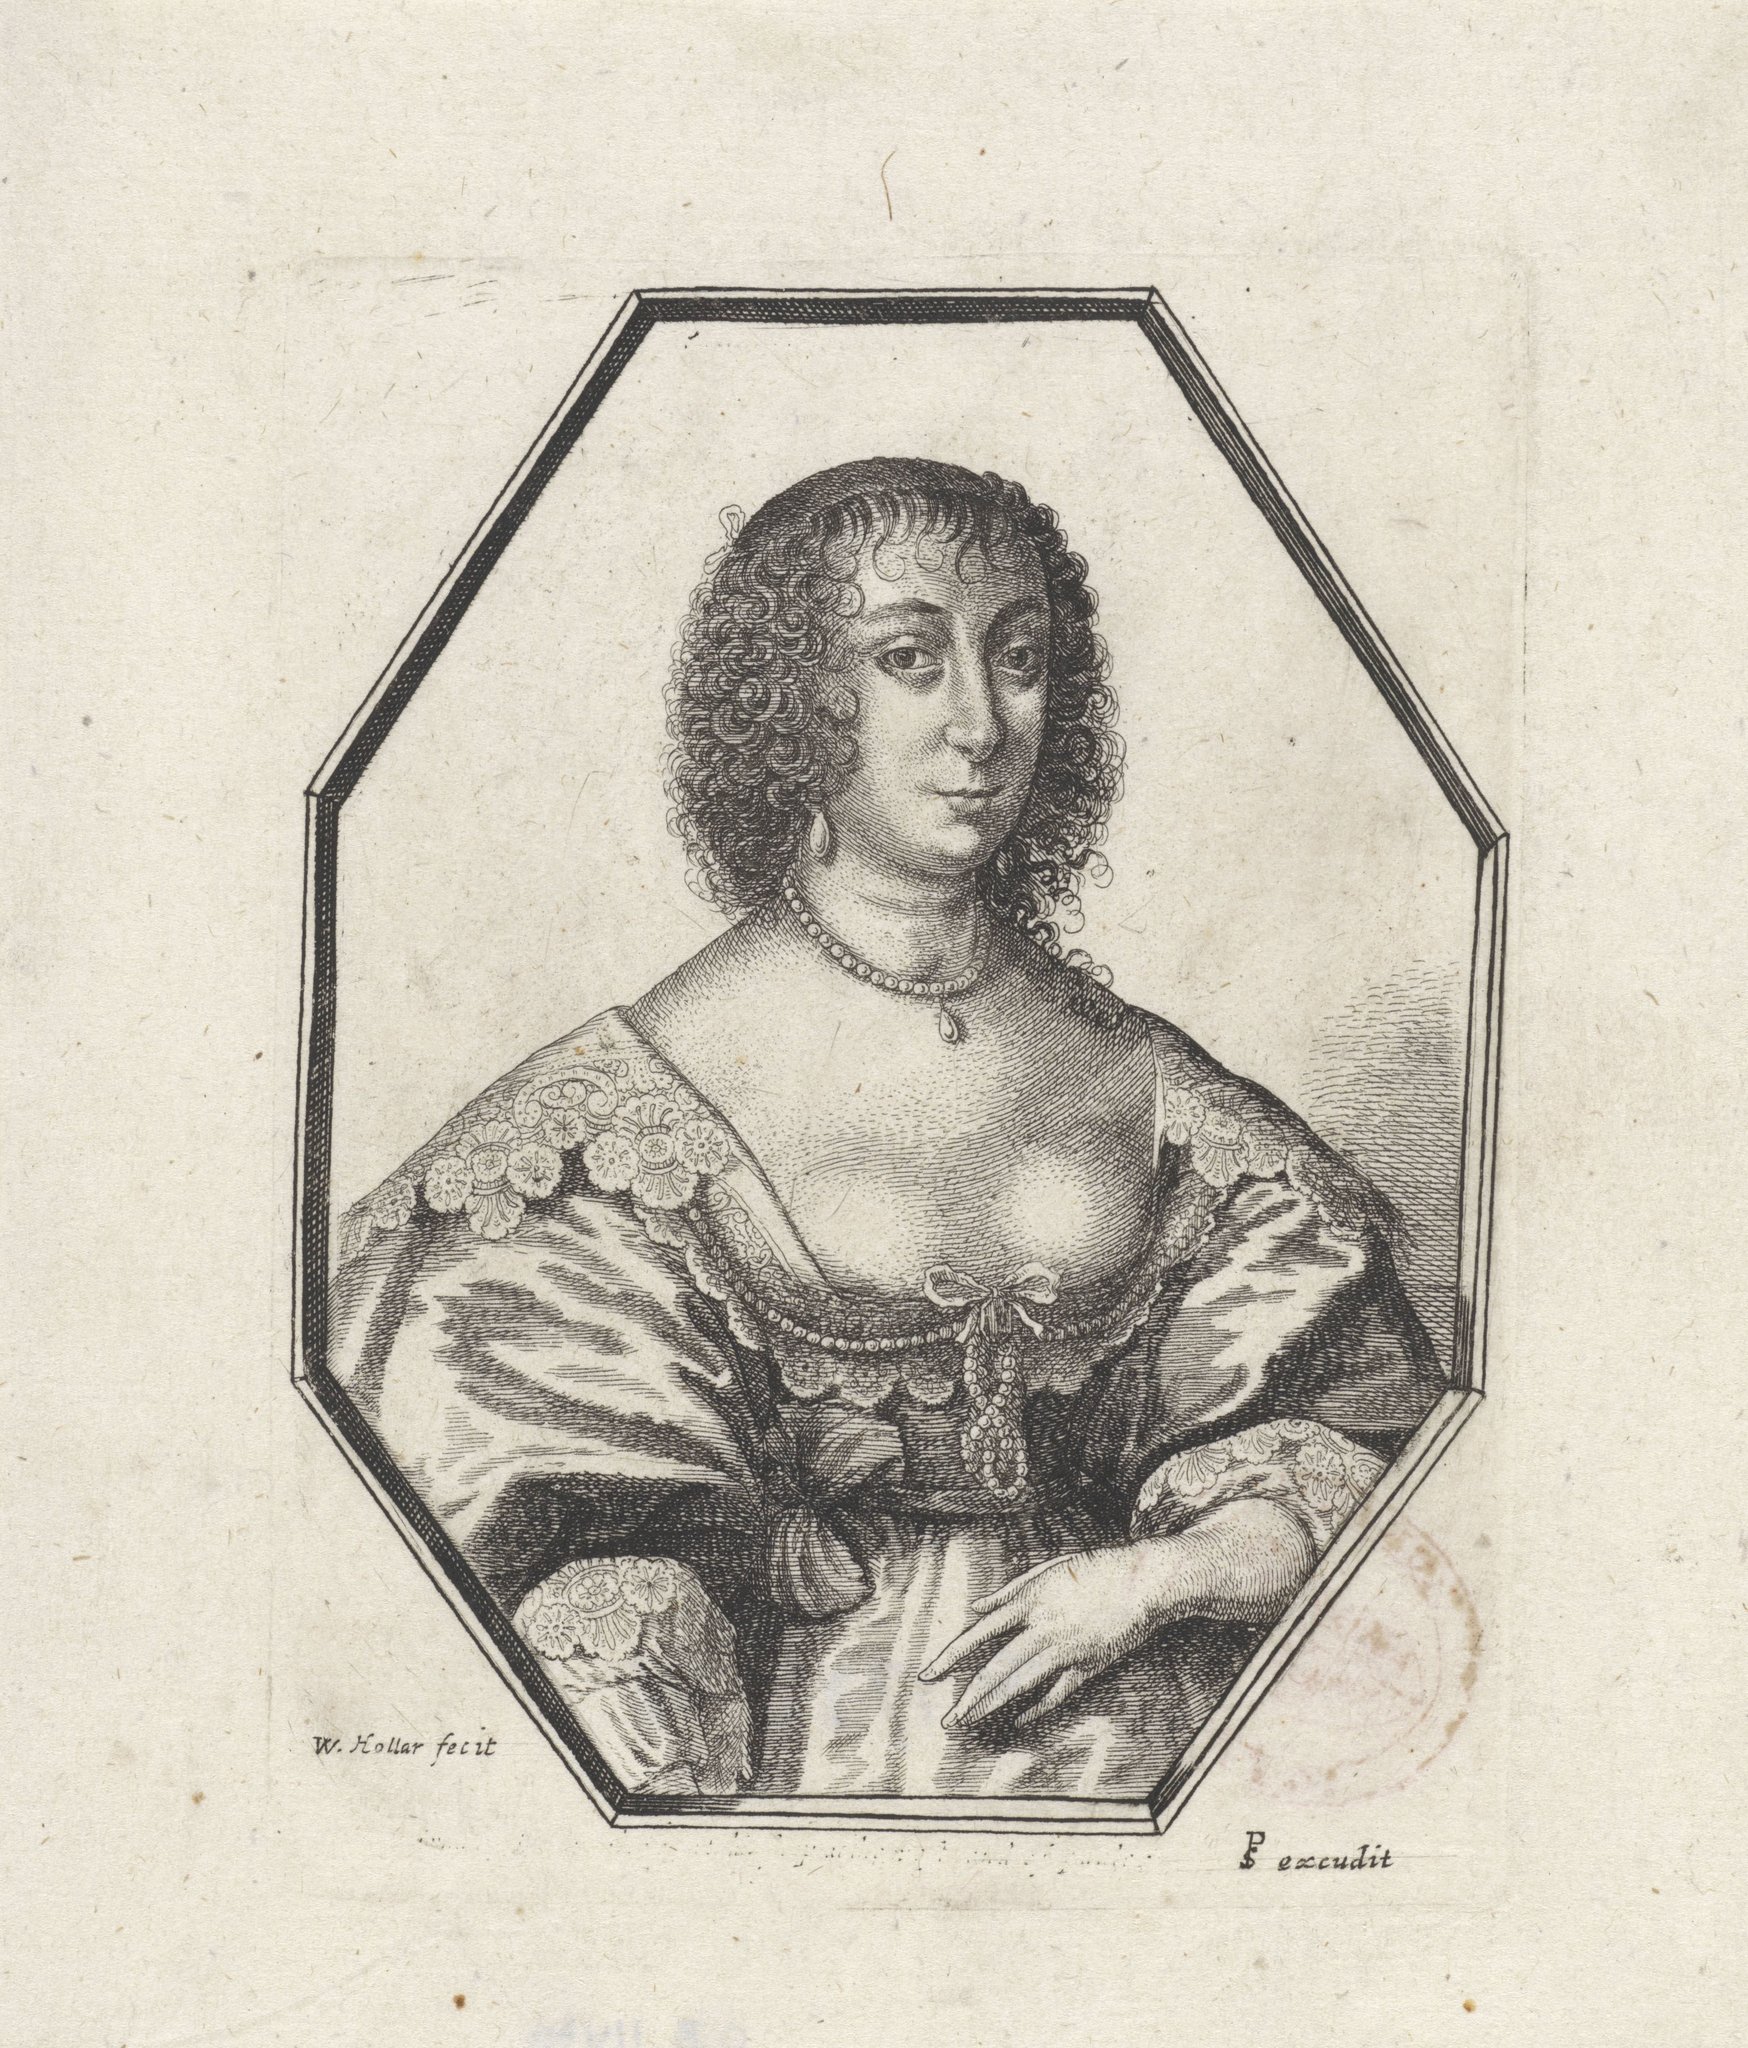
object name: print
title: Portret van een vrouw met parelsnoer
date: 1637-1638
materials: paper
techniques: etching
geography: london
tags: anonymous historical person portrayed alone - bb - woman, pearl; pearl necklace (+ women's clothes)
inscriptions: collector's mark: Lugt 240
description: De prent maakt deel uit van een zesdelige serie met vrouwenportretten in achthoekige lijsten.